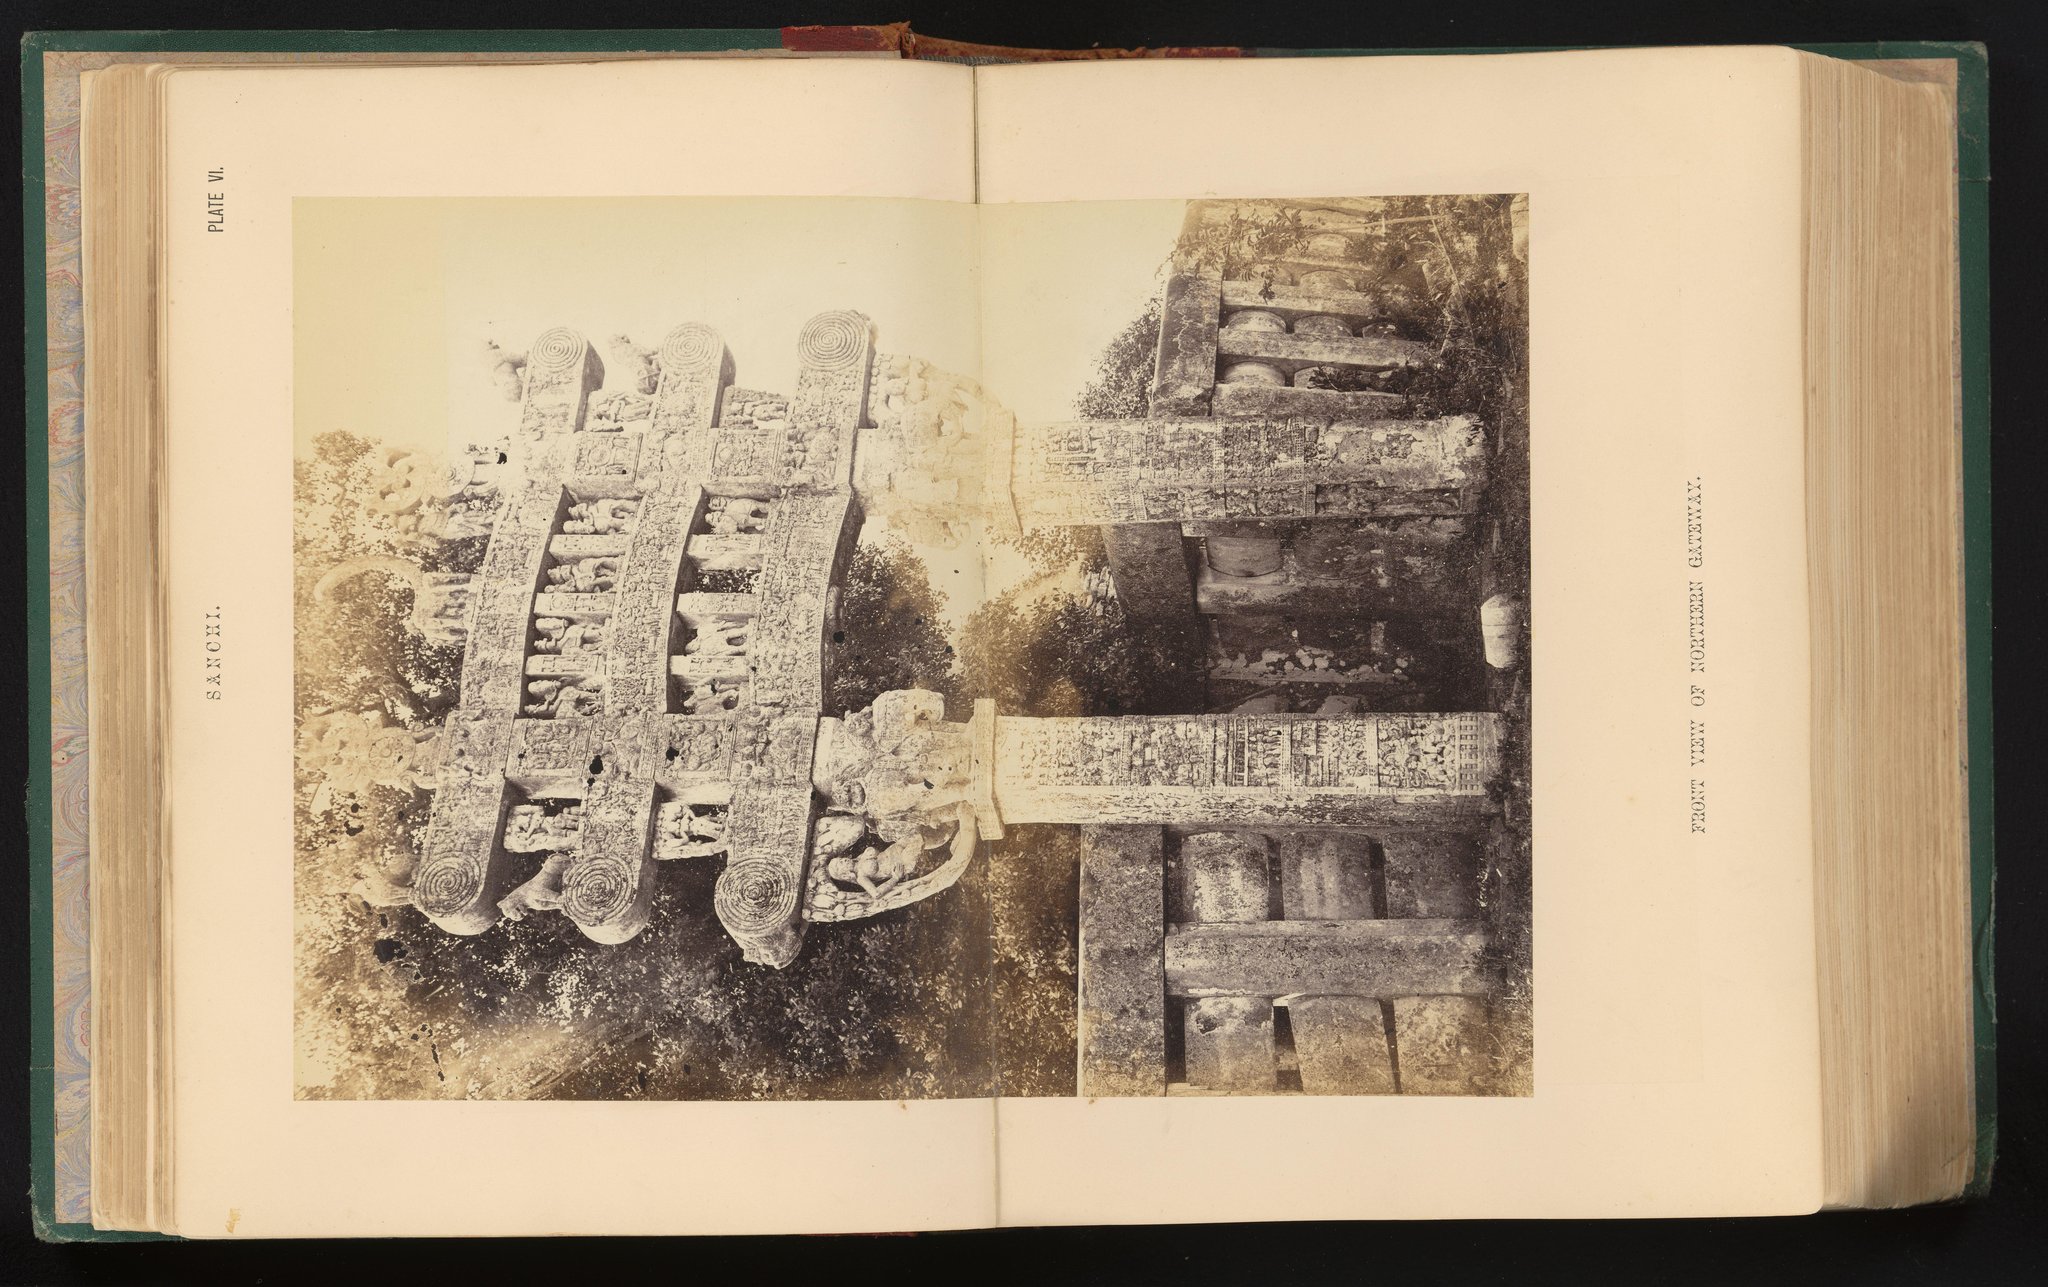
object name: page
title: Northern gateway (torara) by the Great Stupa at Sanchi, Madhya Pradesh, India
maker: james john waterhouse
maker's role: fotograaf, luitenant, officier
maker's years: 1842-1928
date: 1863-1868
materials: photographic support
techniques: albumen print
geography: sanchi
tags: places and objects of worship ~ hinduism, buddhism, jainism, gate, entrance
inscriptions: inscription: ‘SANCHI. PLATE VI./ FRONT VIEW OF NORTHERN GATEWAY.’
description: Foto twee en drie pagina's na pagina 100.